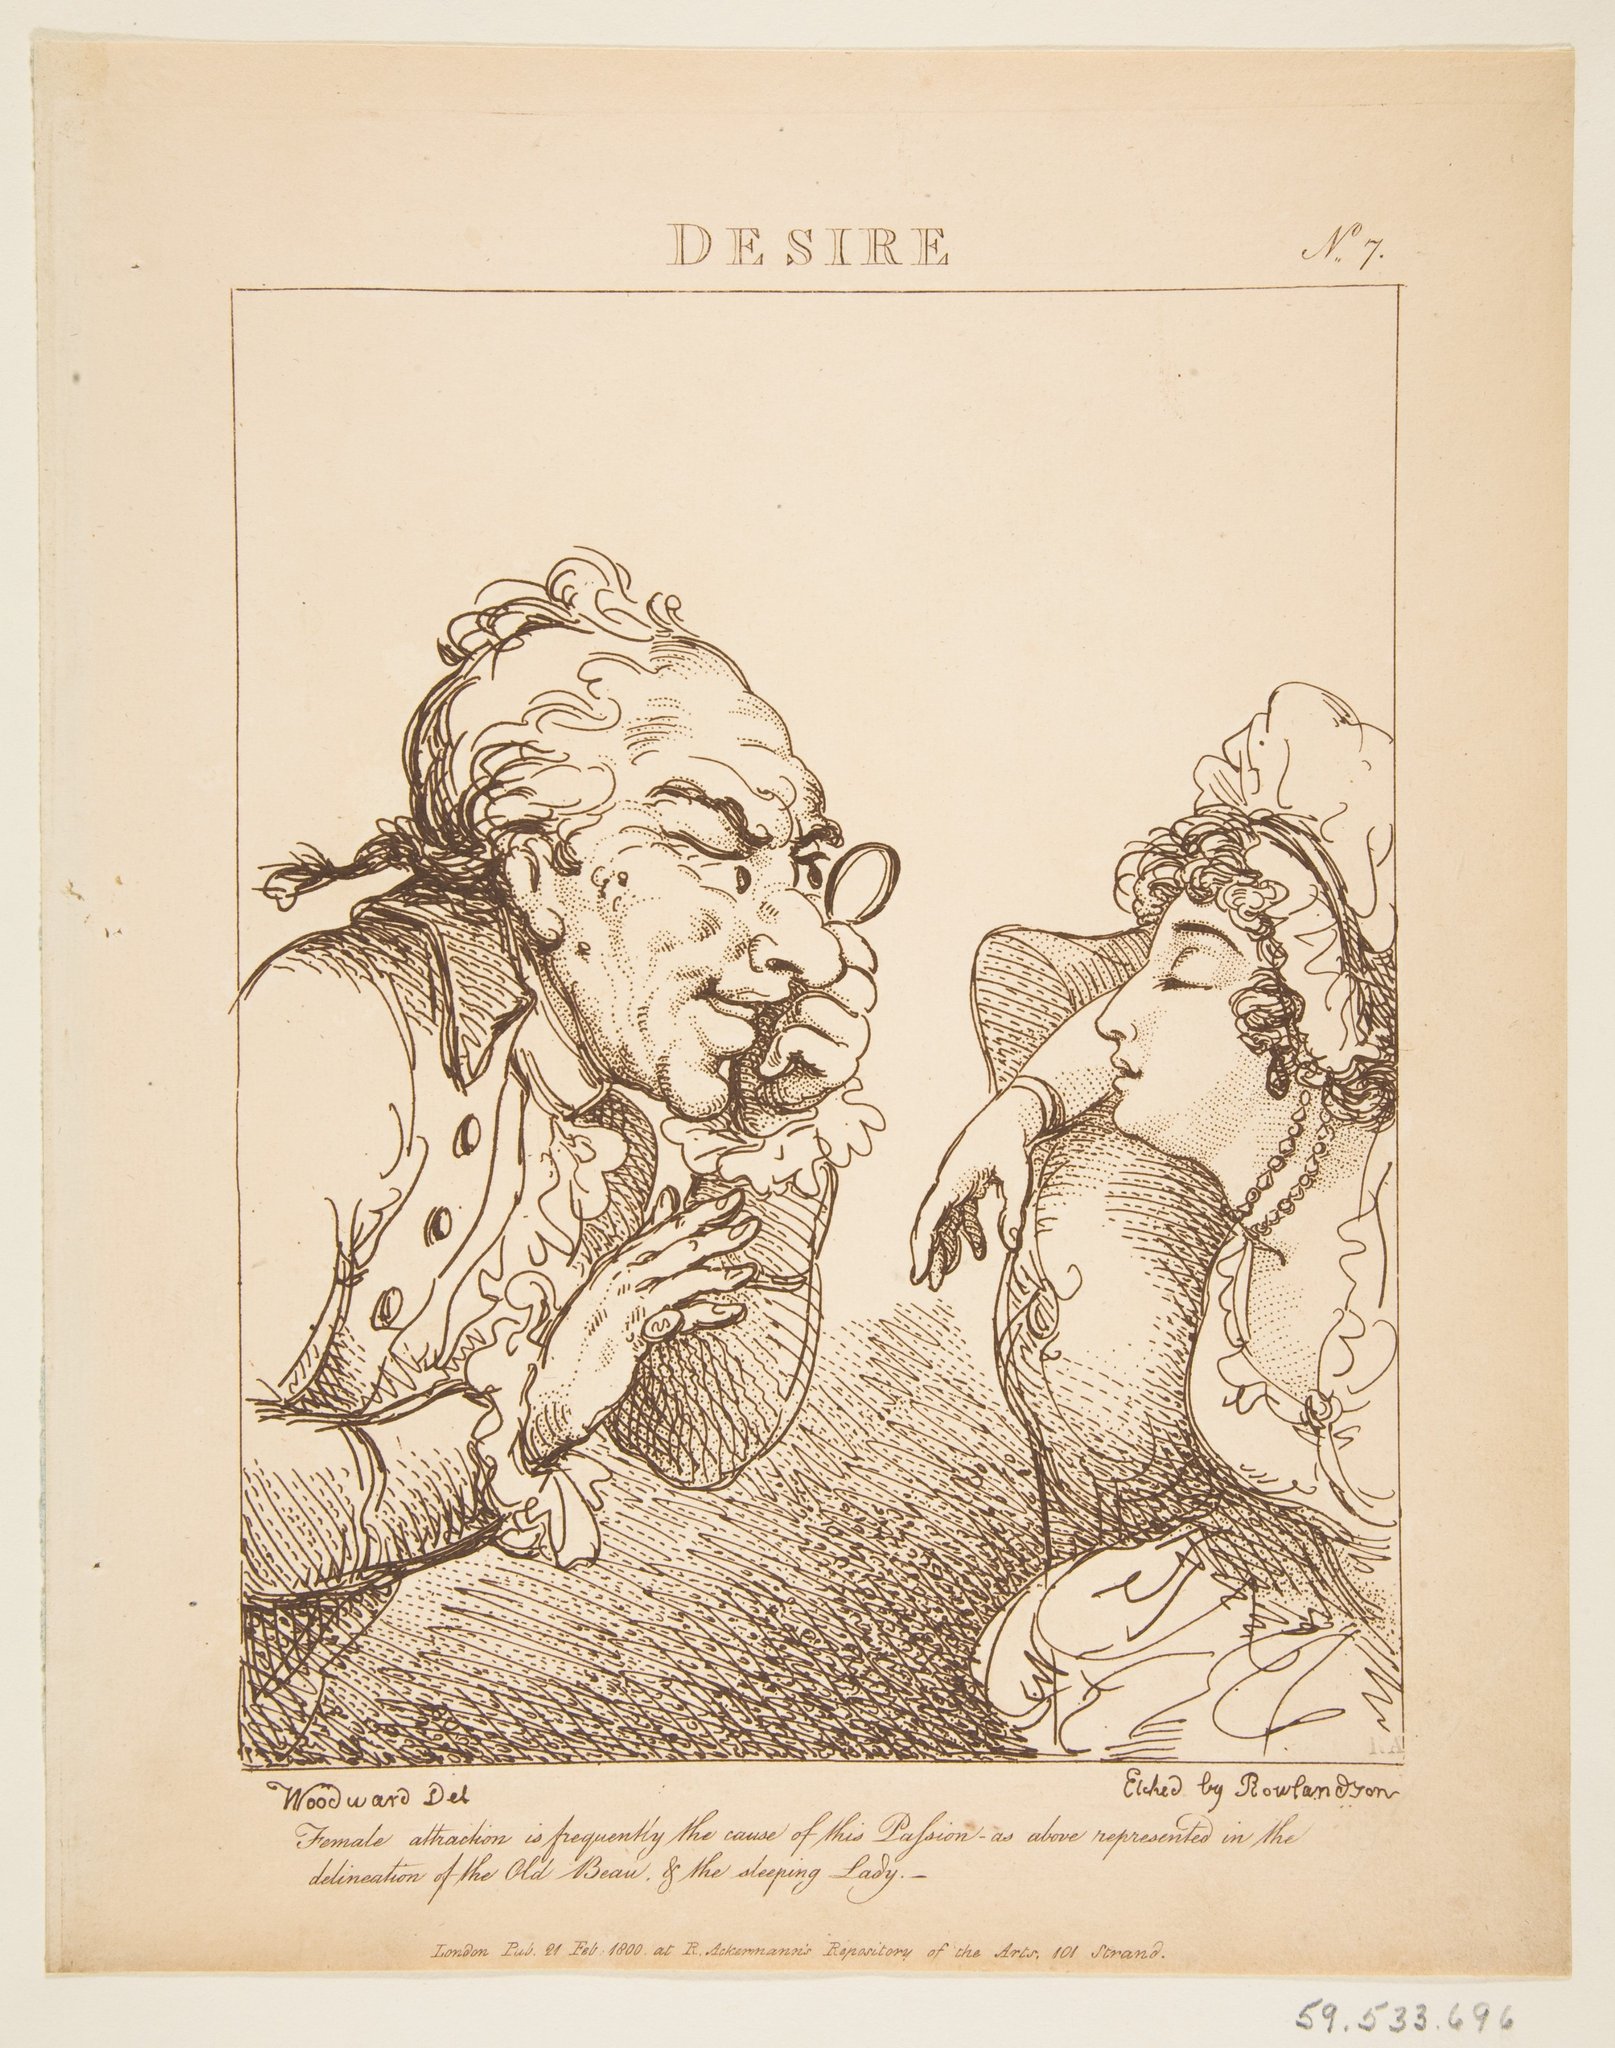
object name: print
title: Desire (Le Brun Travested, or Caricatures of the Passions)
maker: thomas rowlandson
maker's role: artist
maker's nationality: british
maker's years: 1757-1827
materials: ink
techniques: etching, printing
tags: men,women